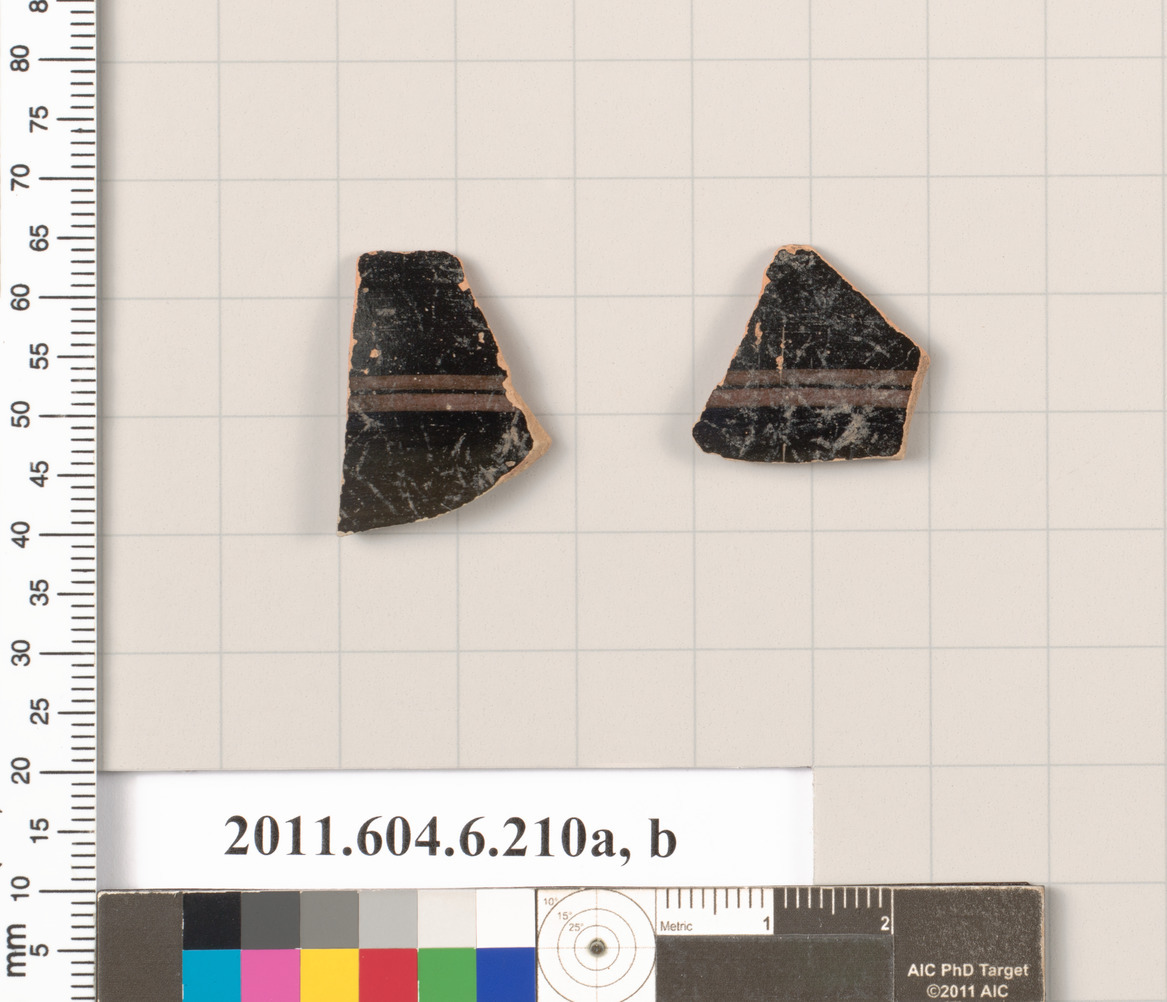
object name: undetermined open shape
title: Terracotta fragments of an open shape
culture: greek, attic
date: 600-401 BCE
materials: terracotta